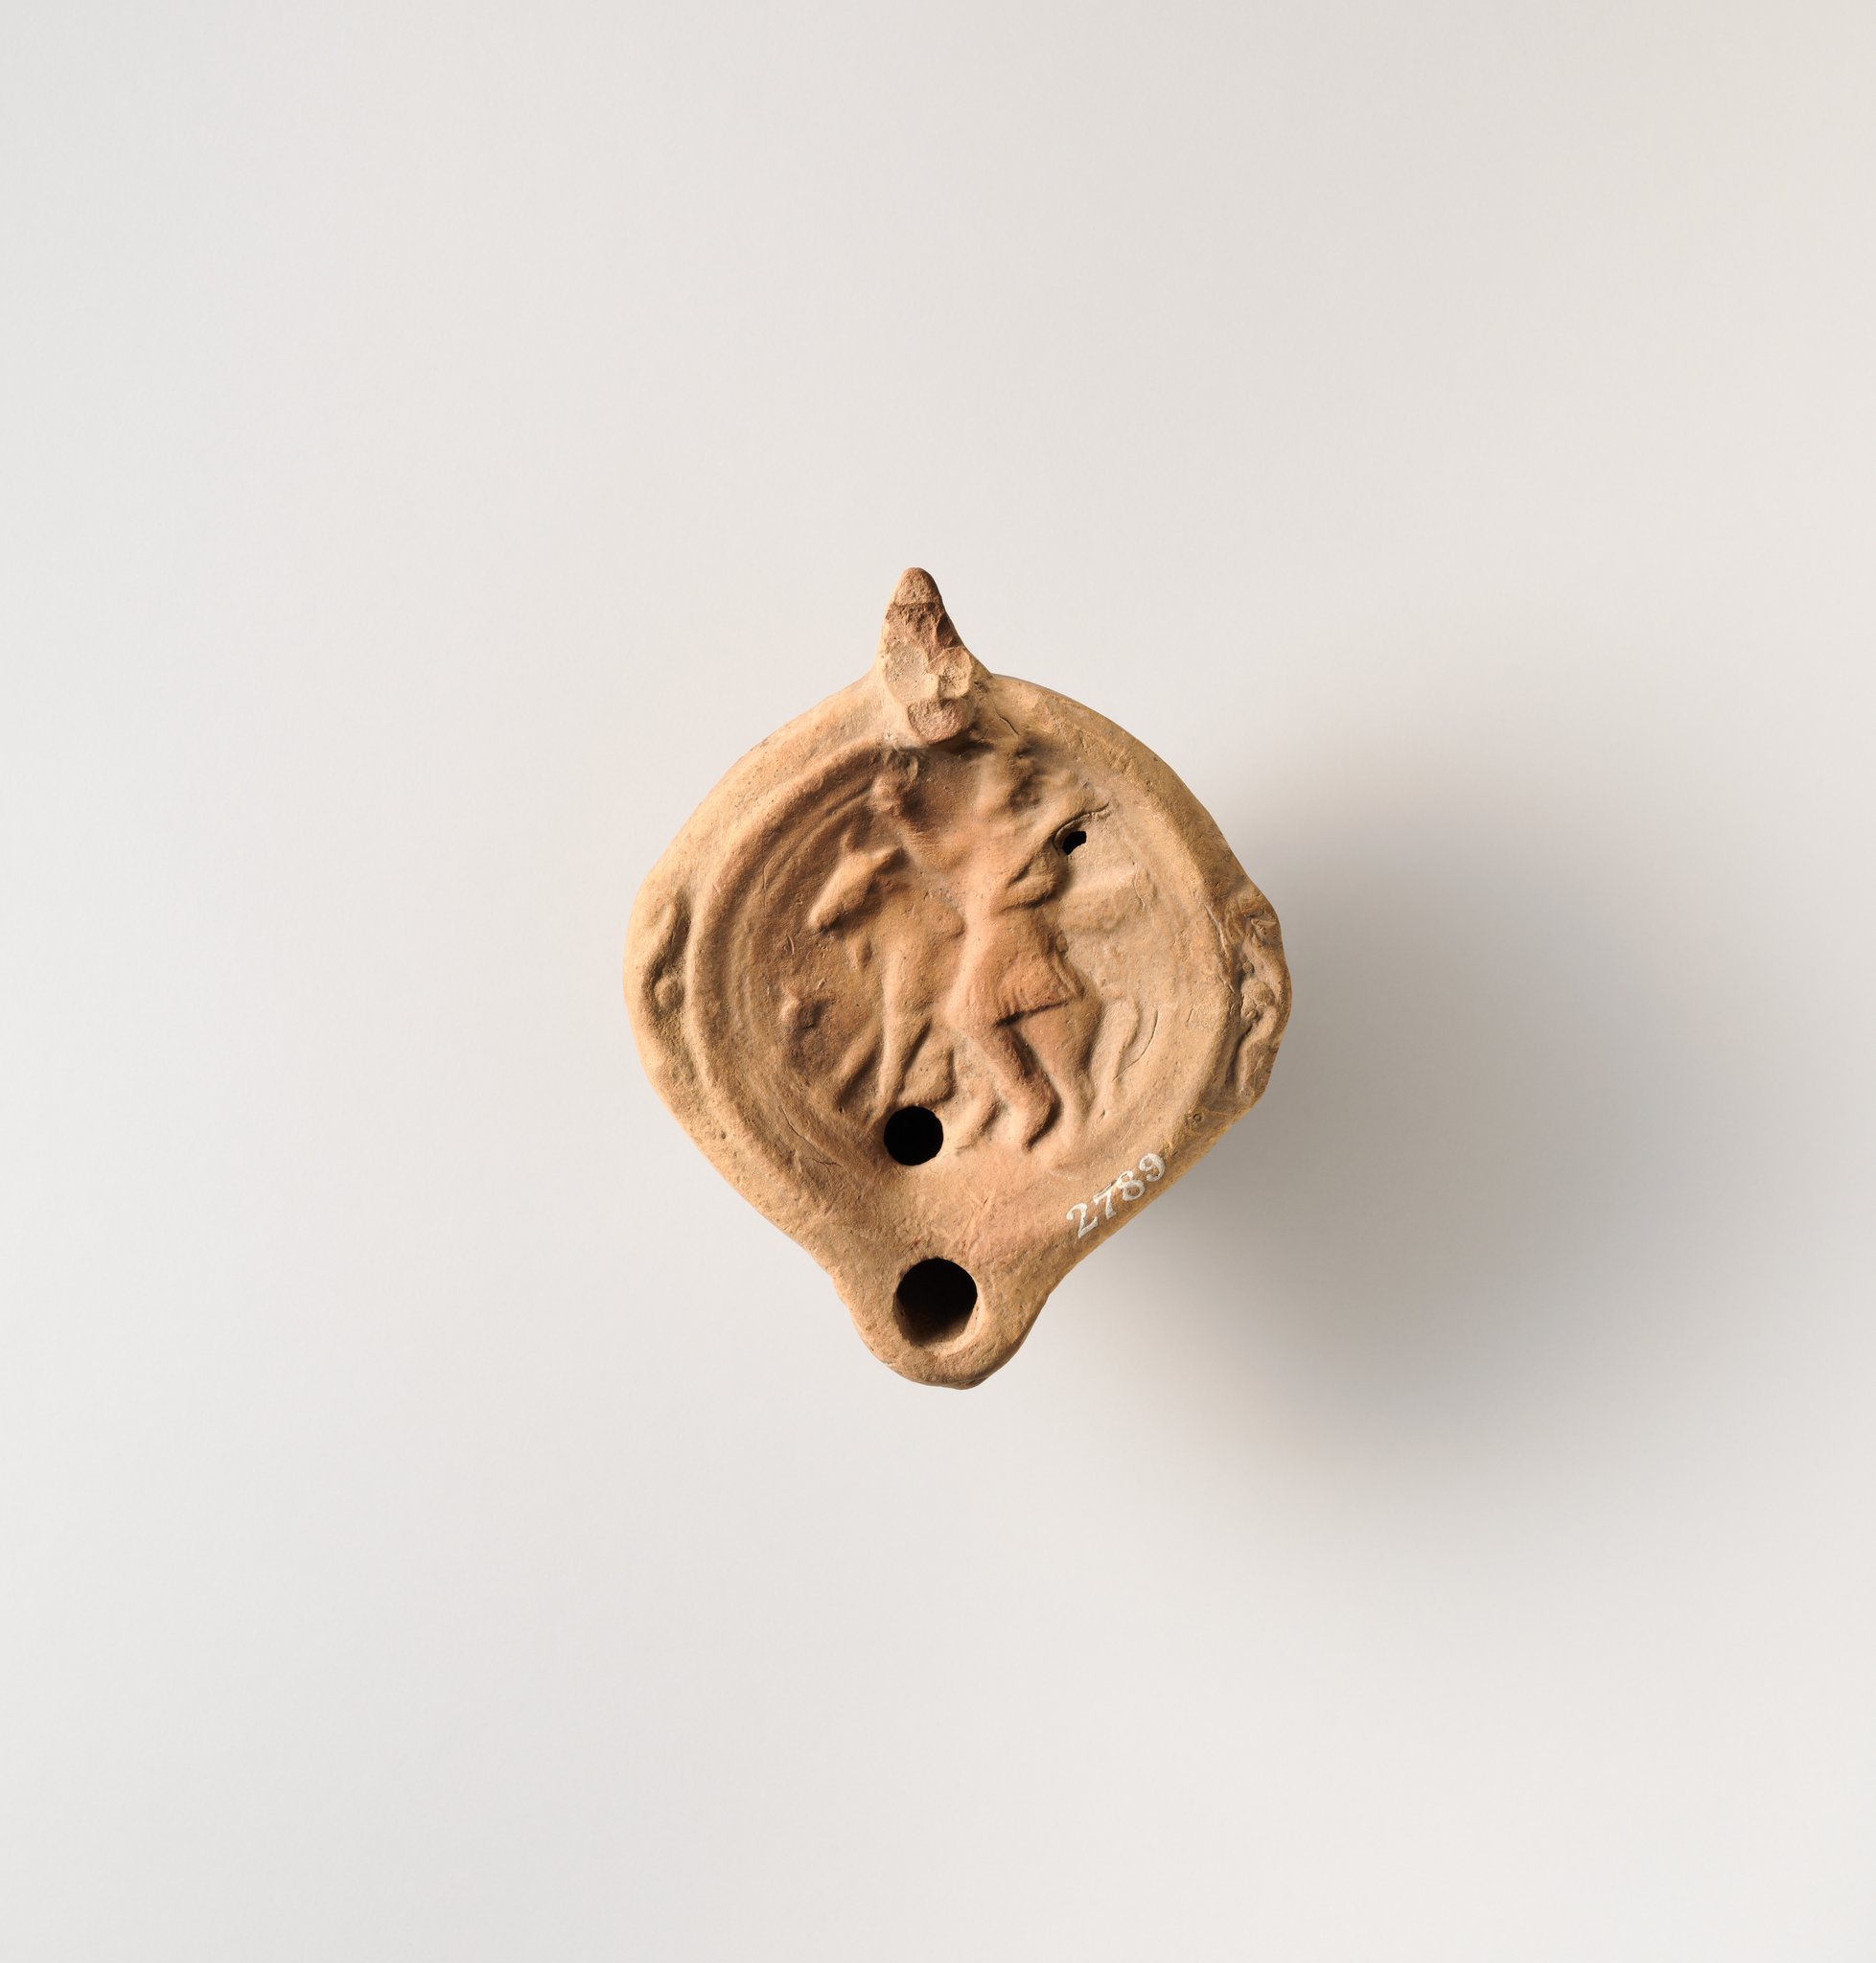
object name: lamp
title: Terracotta oil lamp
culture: roman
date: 101-200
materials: terracotta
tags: bulls